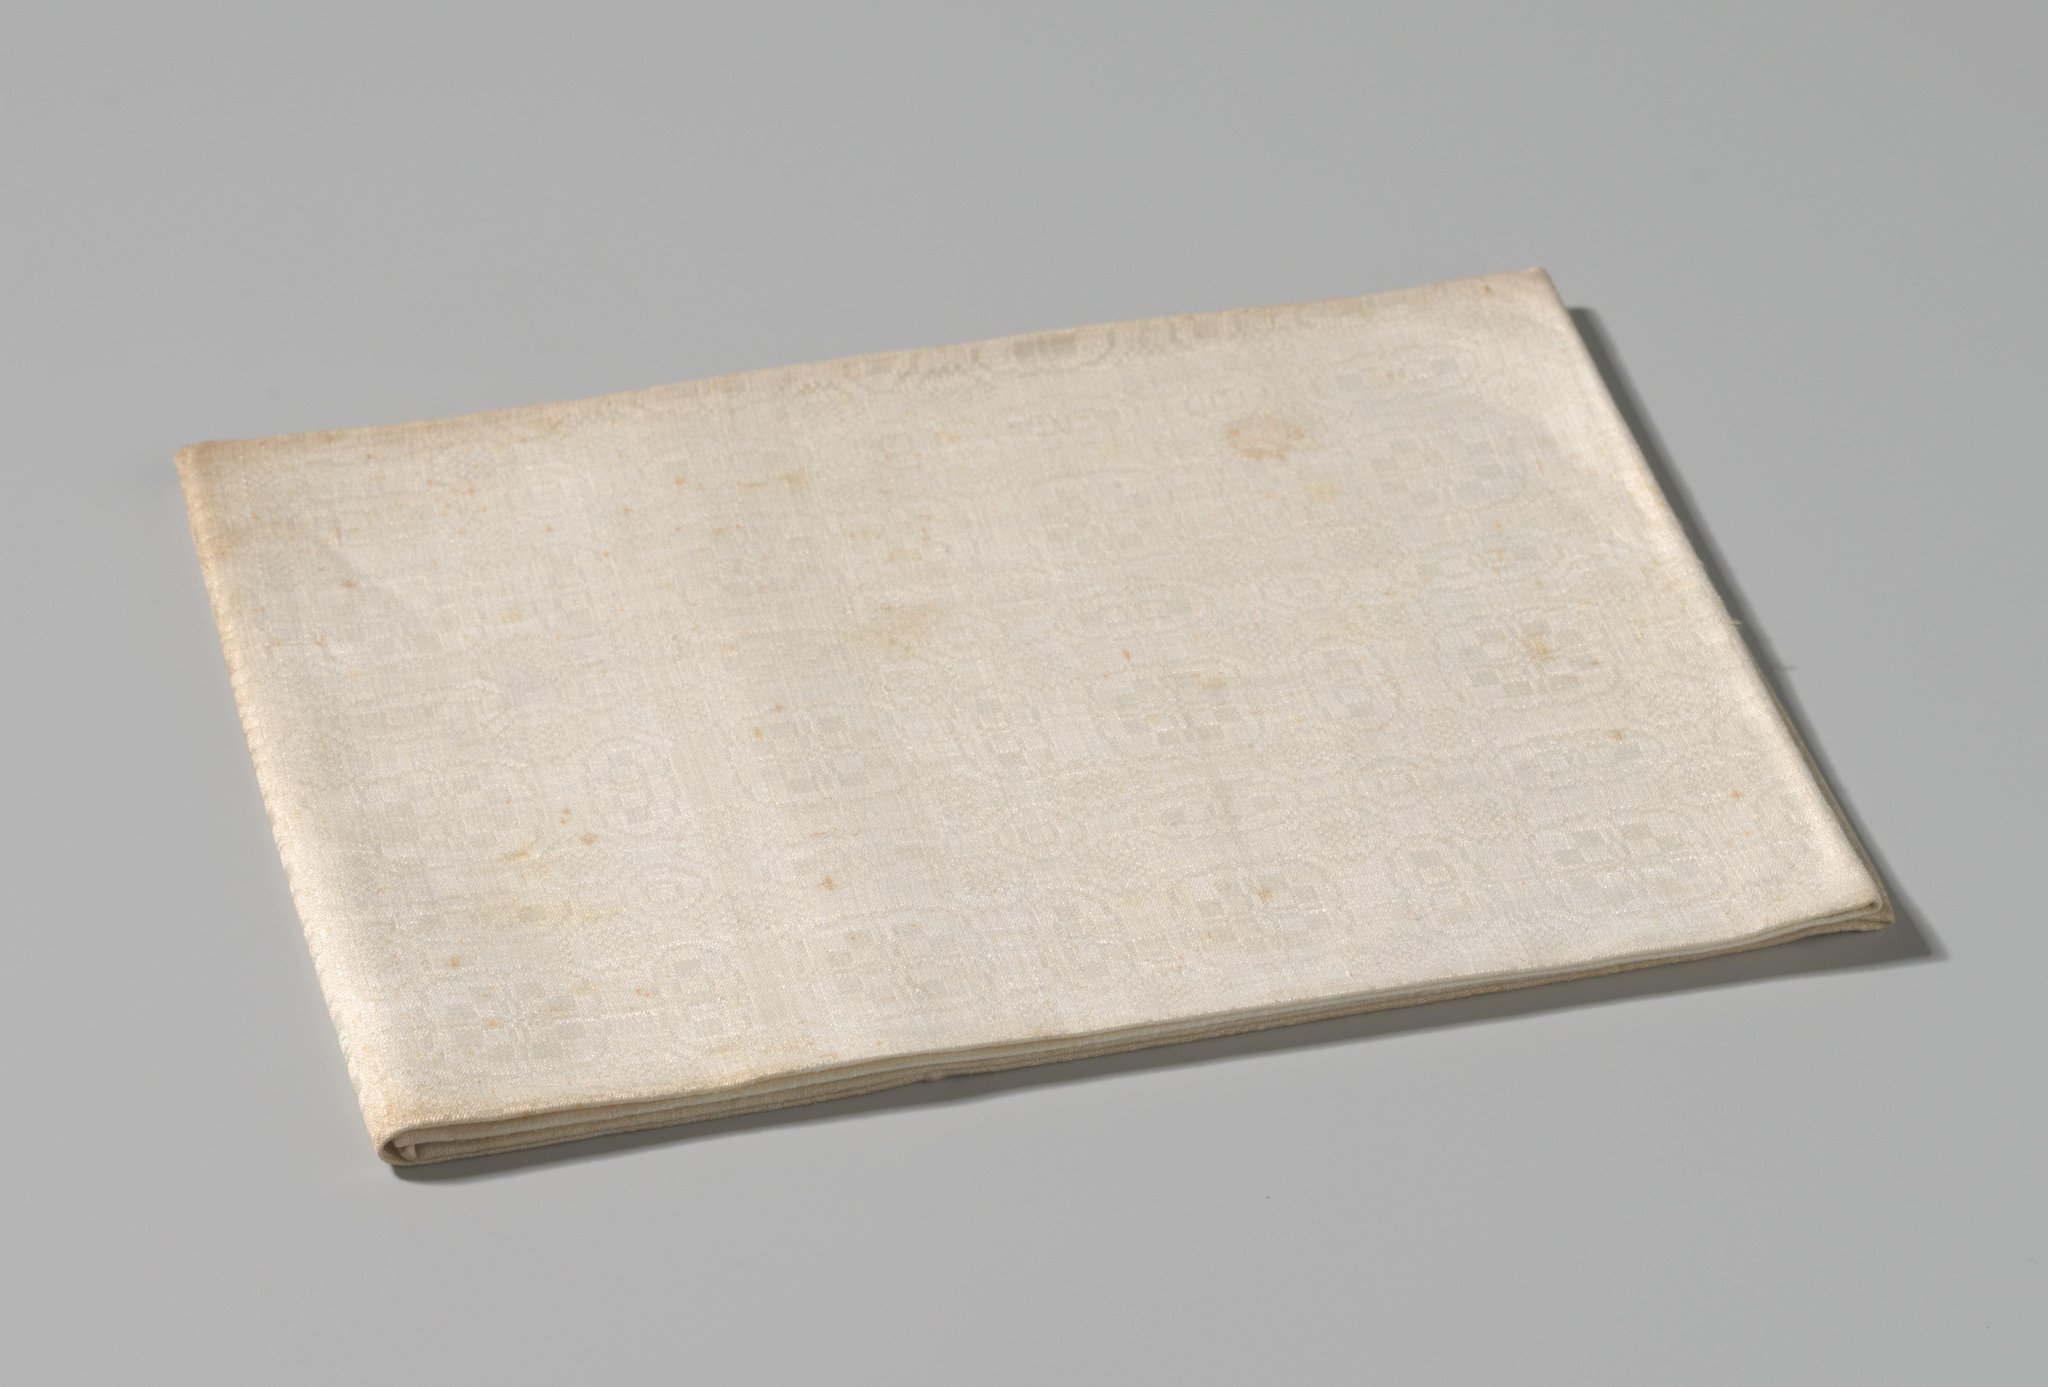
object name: napkin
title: Servet van linnen met pellenpatroon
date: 1692-1735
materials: linen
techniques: peeled fabric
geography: northern netherlands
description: wit linnen servet met een pellen patroon, merk kroon GS 36